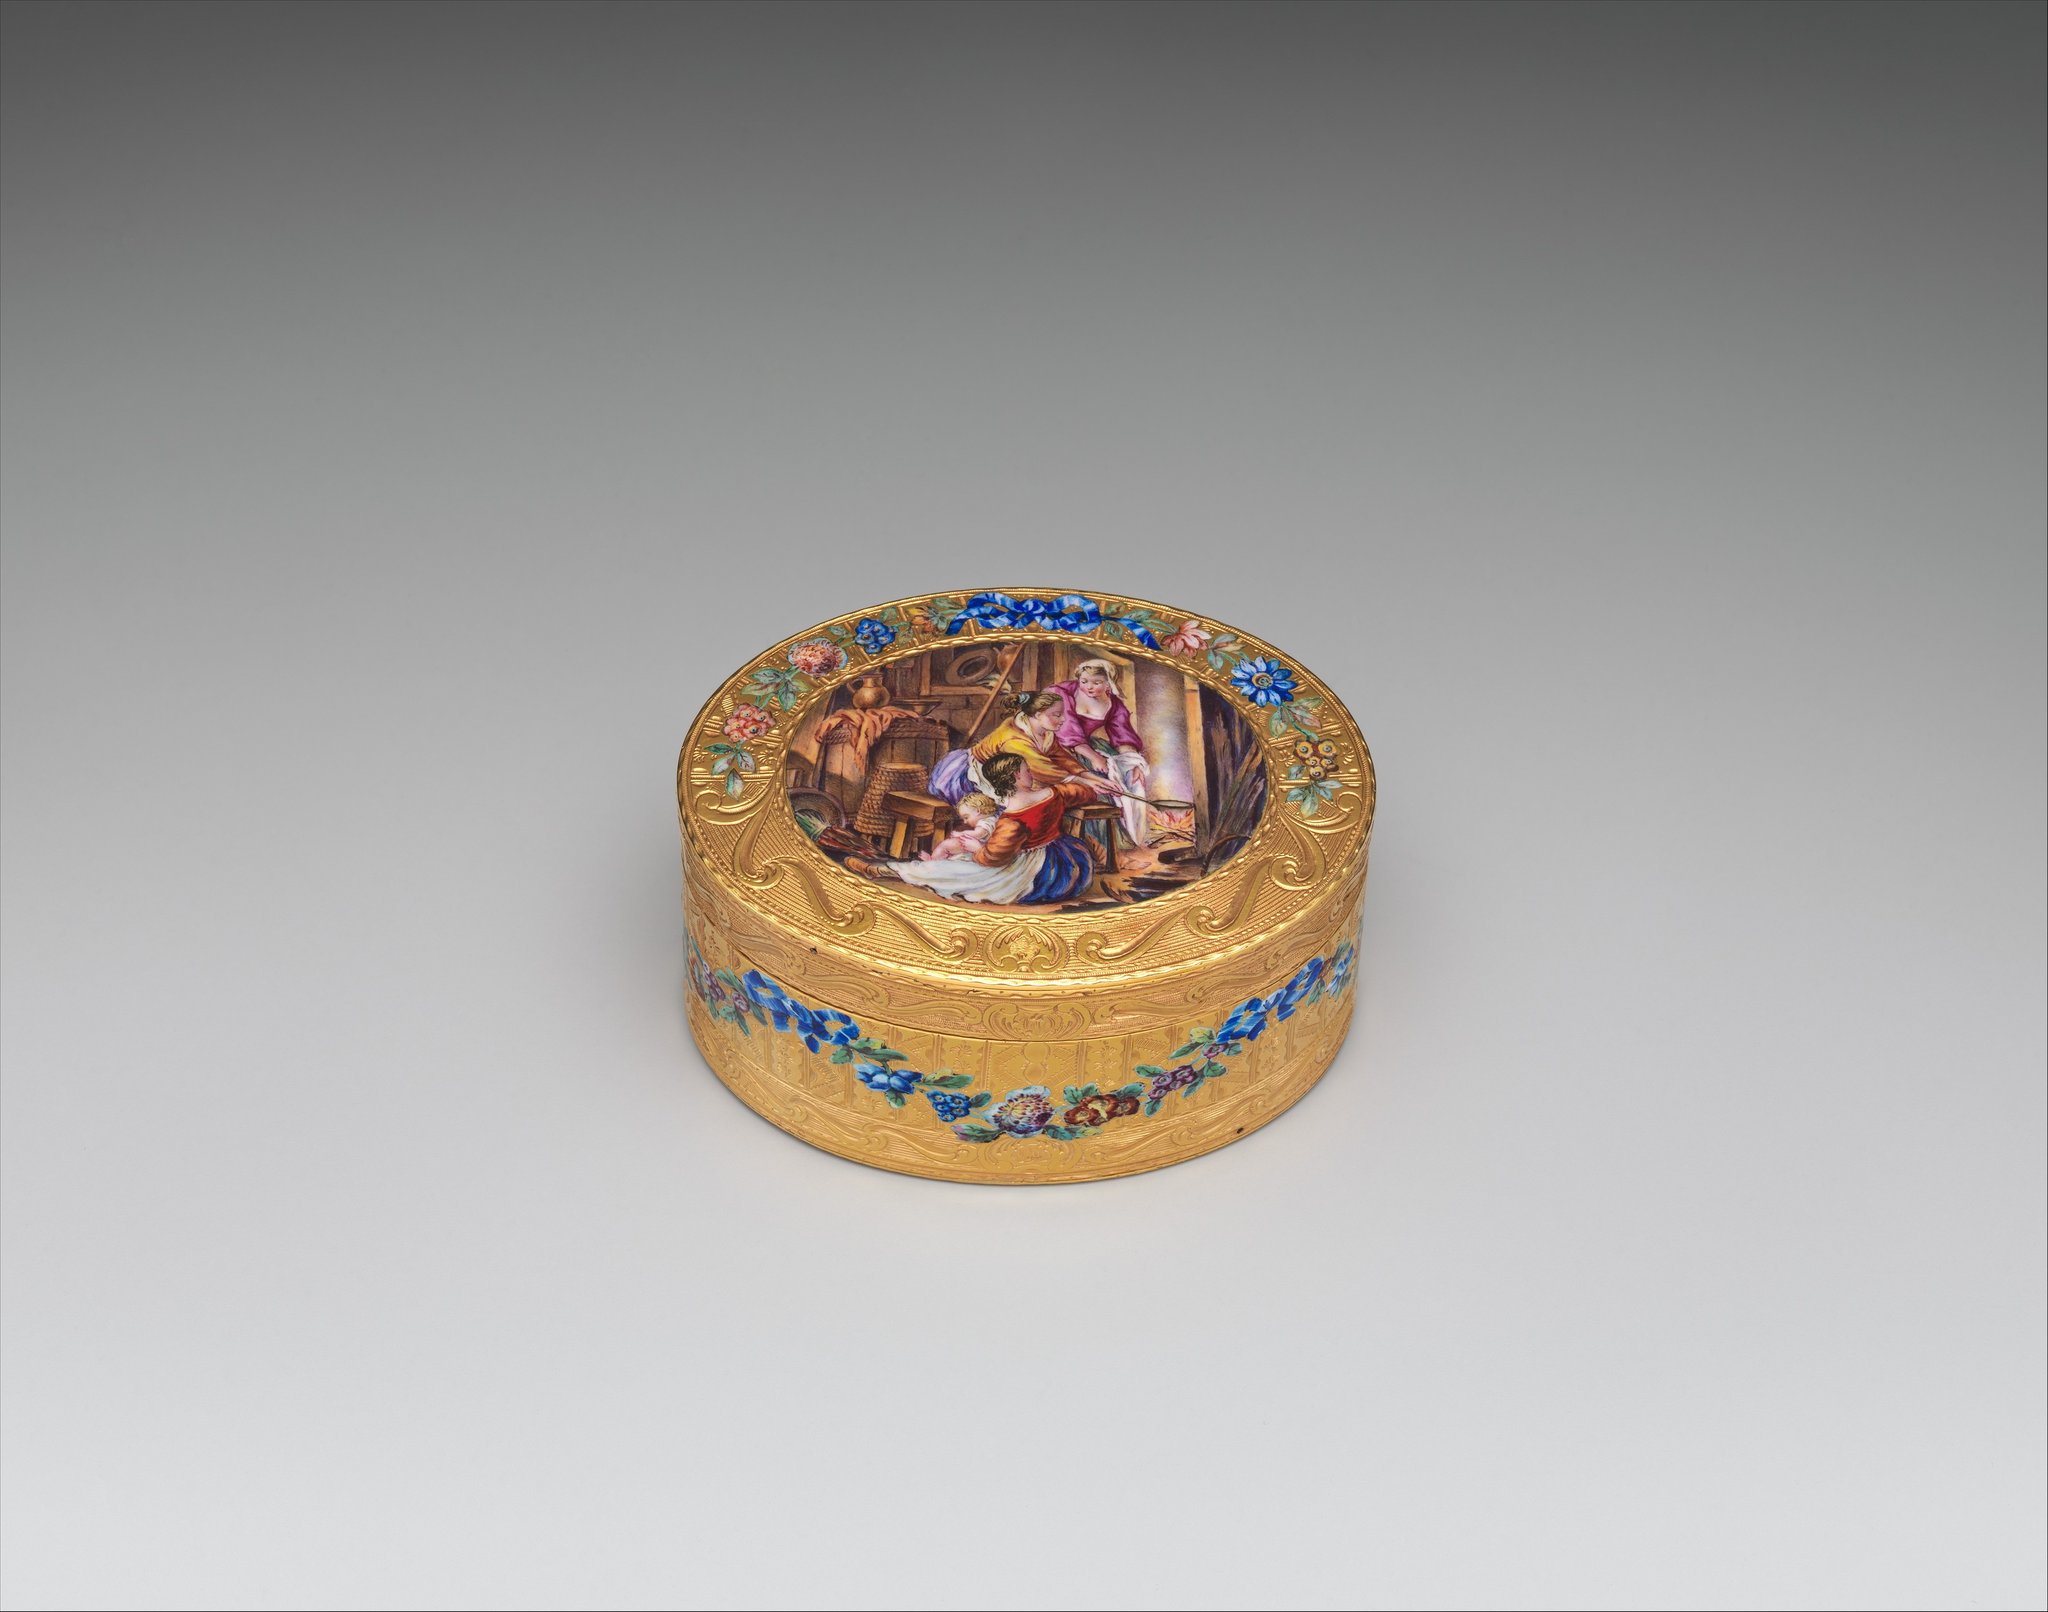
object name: snuffbox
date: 1762-1768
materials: enamel, gold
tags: women,working